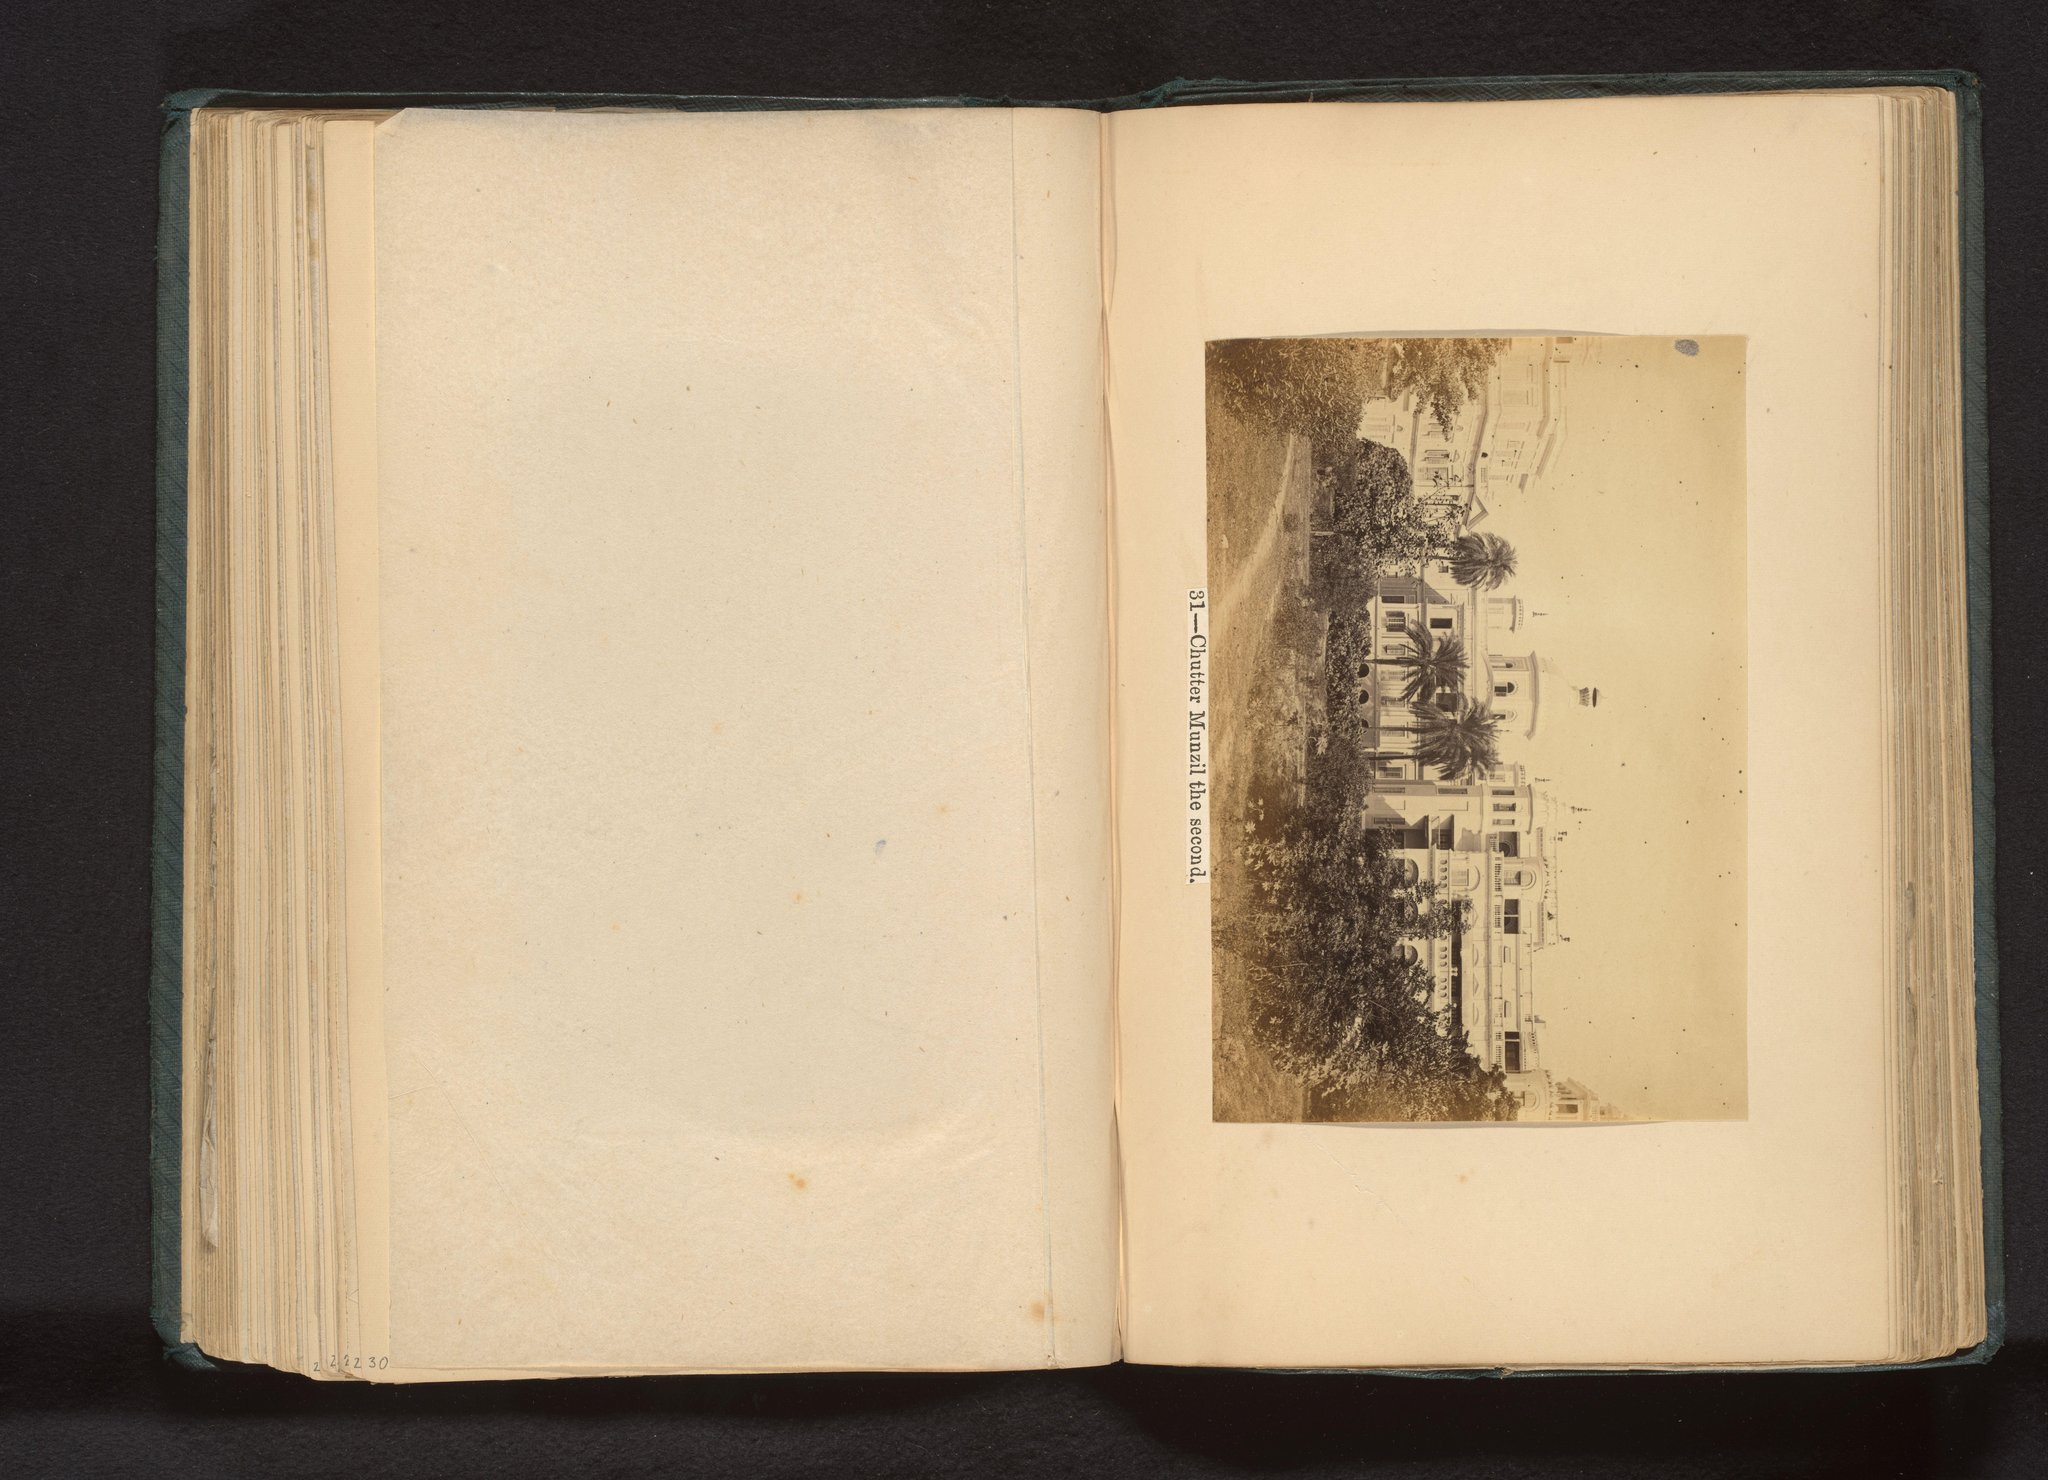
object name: page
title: Chutter Munzil the second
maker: darogha ubbas alli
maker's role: fotograaf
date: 1864-1874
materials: photographic support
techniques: albumen print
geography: lucknow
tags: palace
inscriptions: number: ‘31’